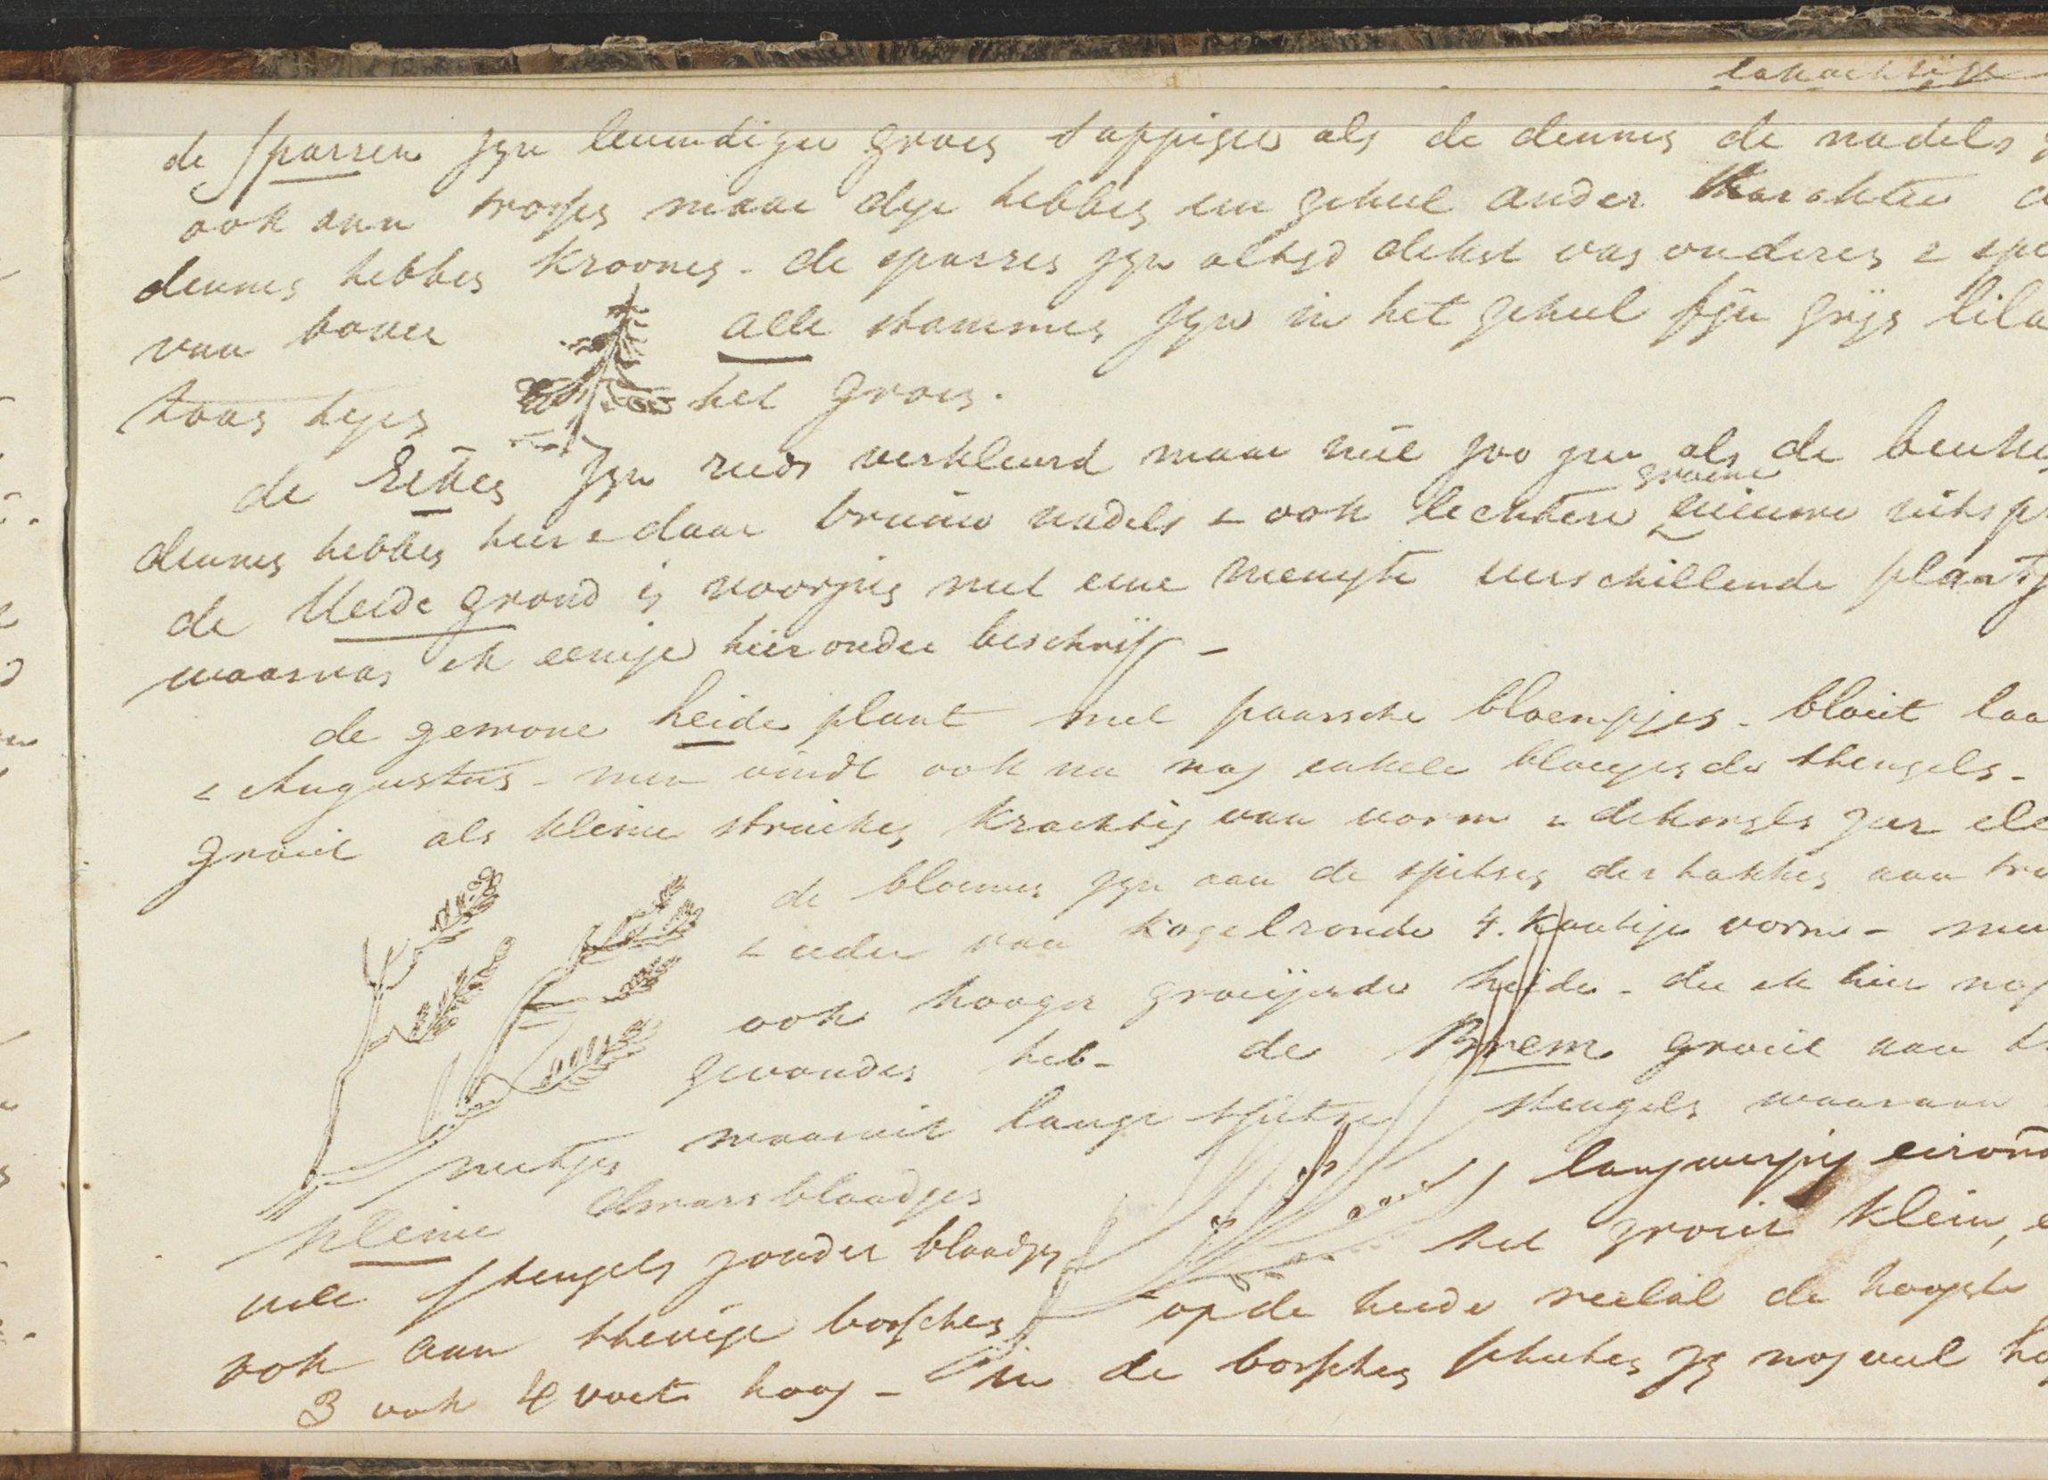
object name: sketchbook leaf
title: Takken van een spar en brem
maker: johannes tavenraat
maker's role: draughtsman, painter, print maker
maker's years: 1809-1881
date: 1810-1843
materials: ink, paper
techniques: pen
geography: cleves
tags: shrubs, trees: fir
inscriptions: annotation: ‘[...]’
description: Blad 35 recto uit een schetsboek met 38 bladen.